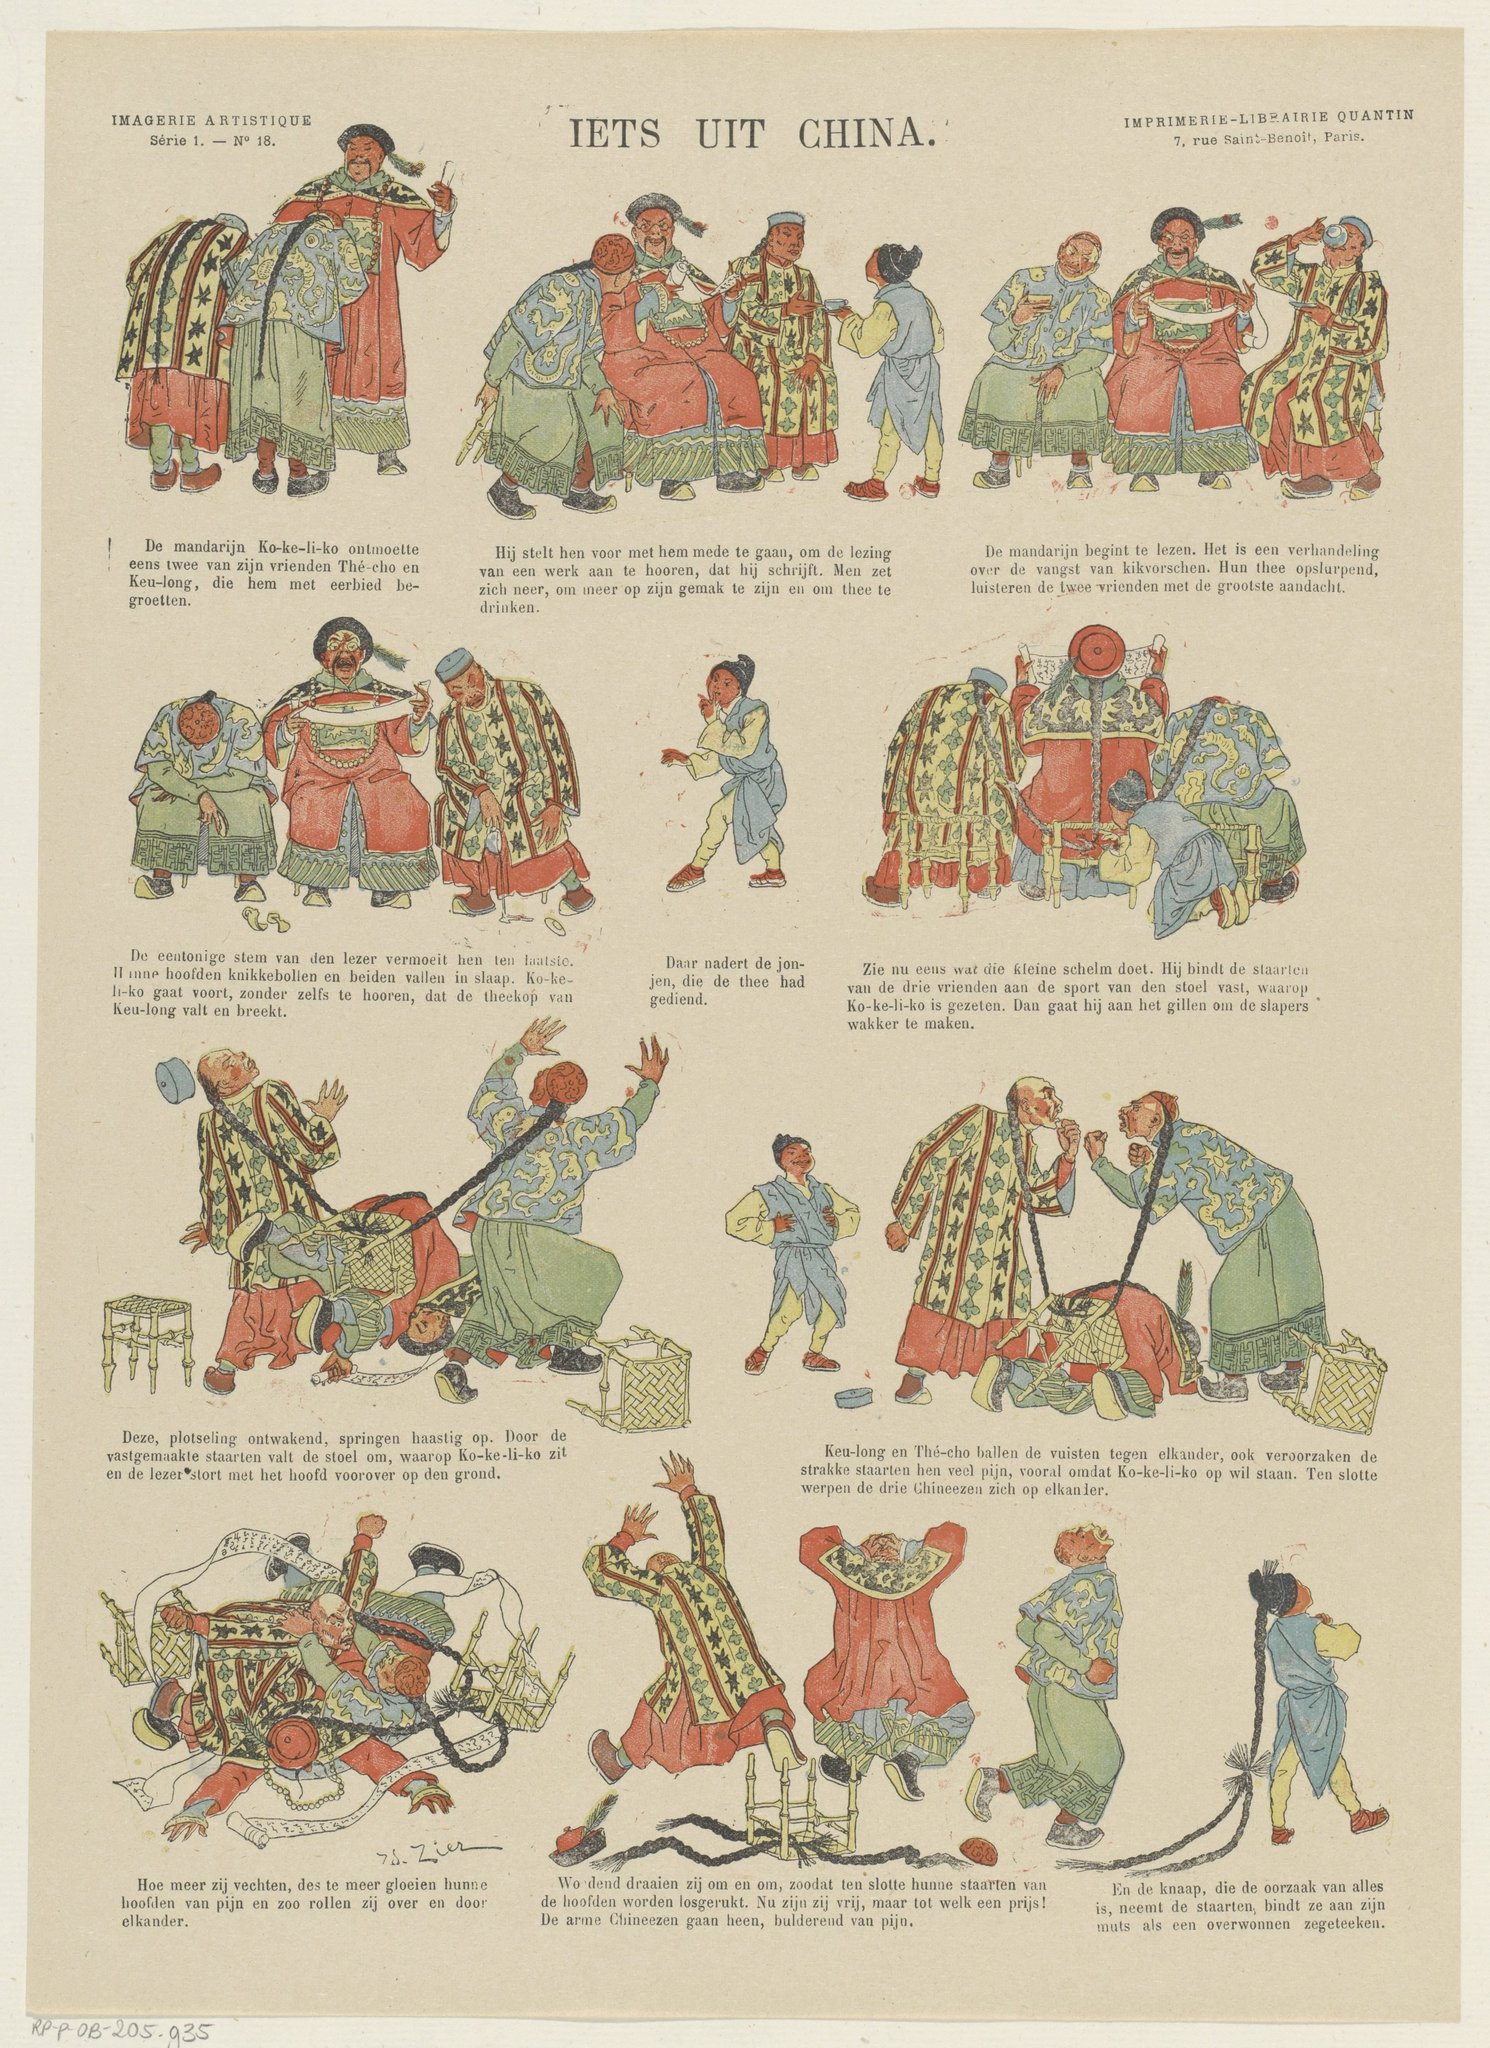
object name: popular print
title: Imagerie Artistique / Série 1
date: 1876-1890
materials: paper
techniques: lithograph, letterpress printing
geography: paris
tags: mischief-making play, chinese, tales and fairy tales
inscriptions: collector's mark: Lugt 2760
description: Blad met 11 voorstellingen van een kwajongen die de staarten van drie oude chinezen aan elkaar knoopt. Onder elke voorstelling een onderschrift. Genummerd linksboven: Série 1. - No. 18.